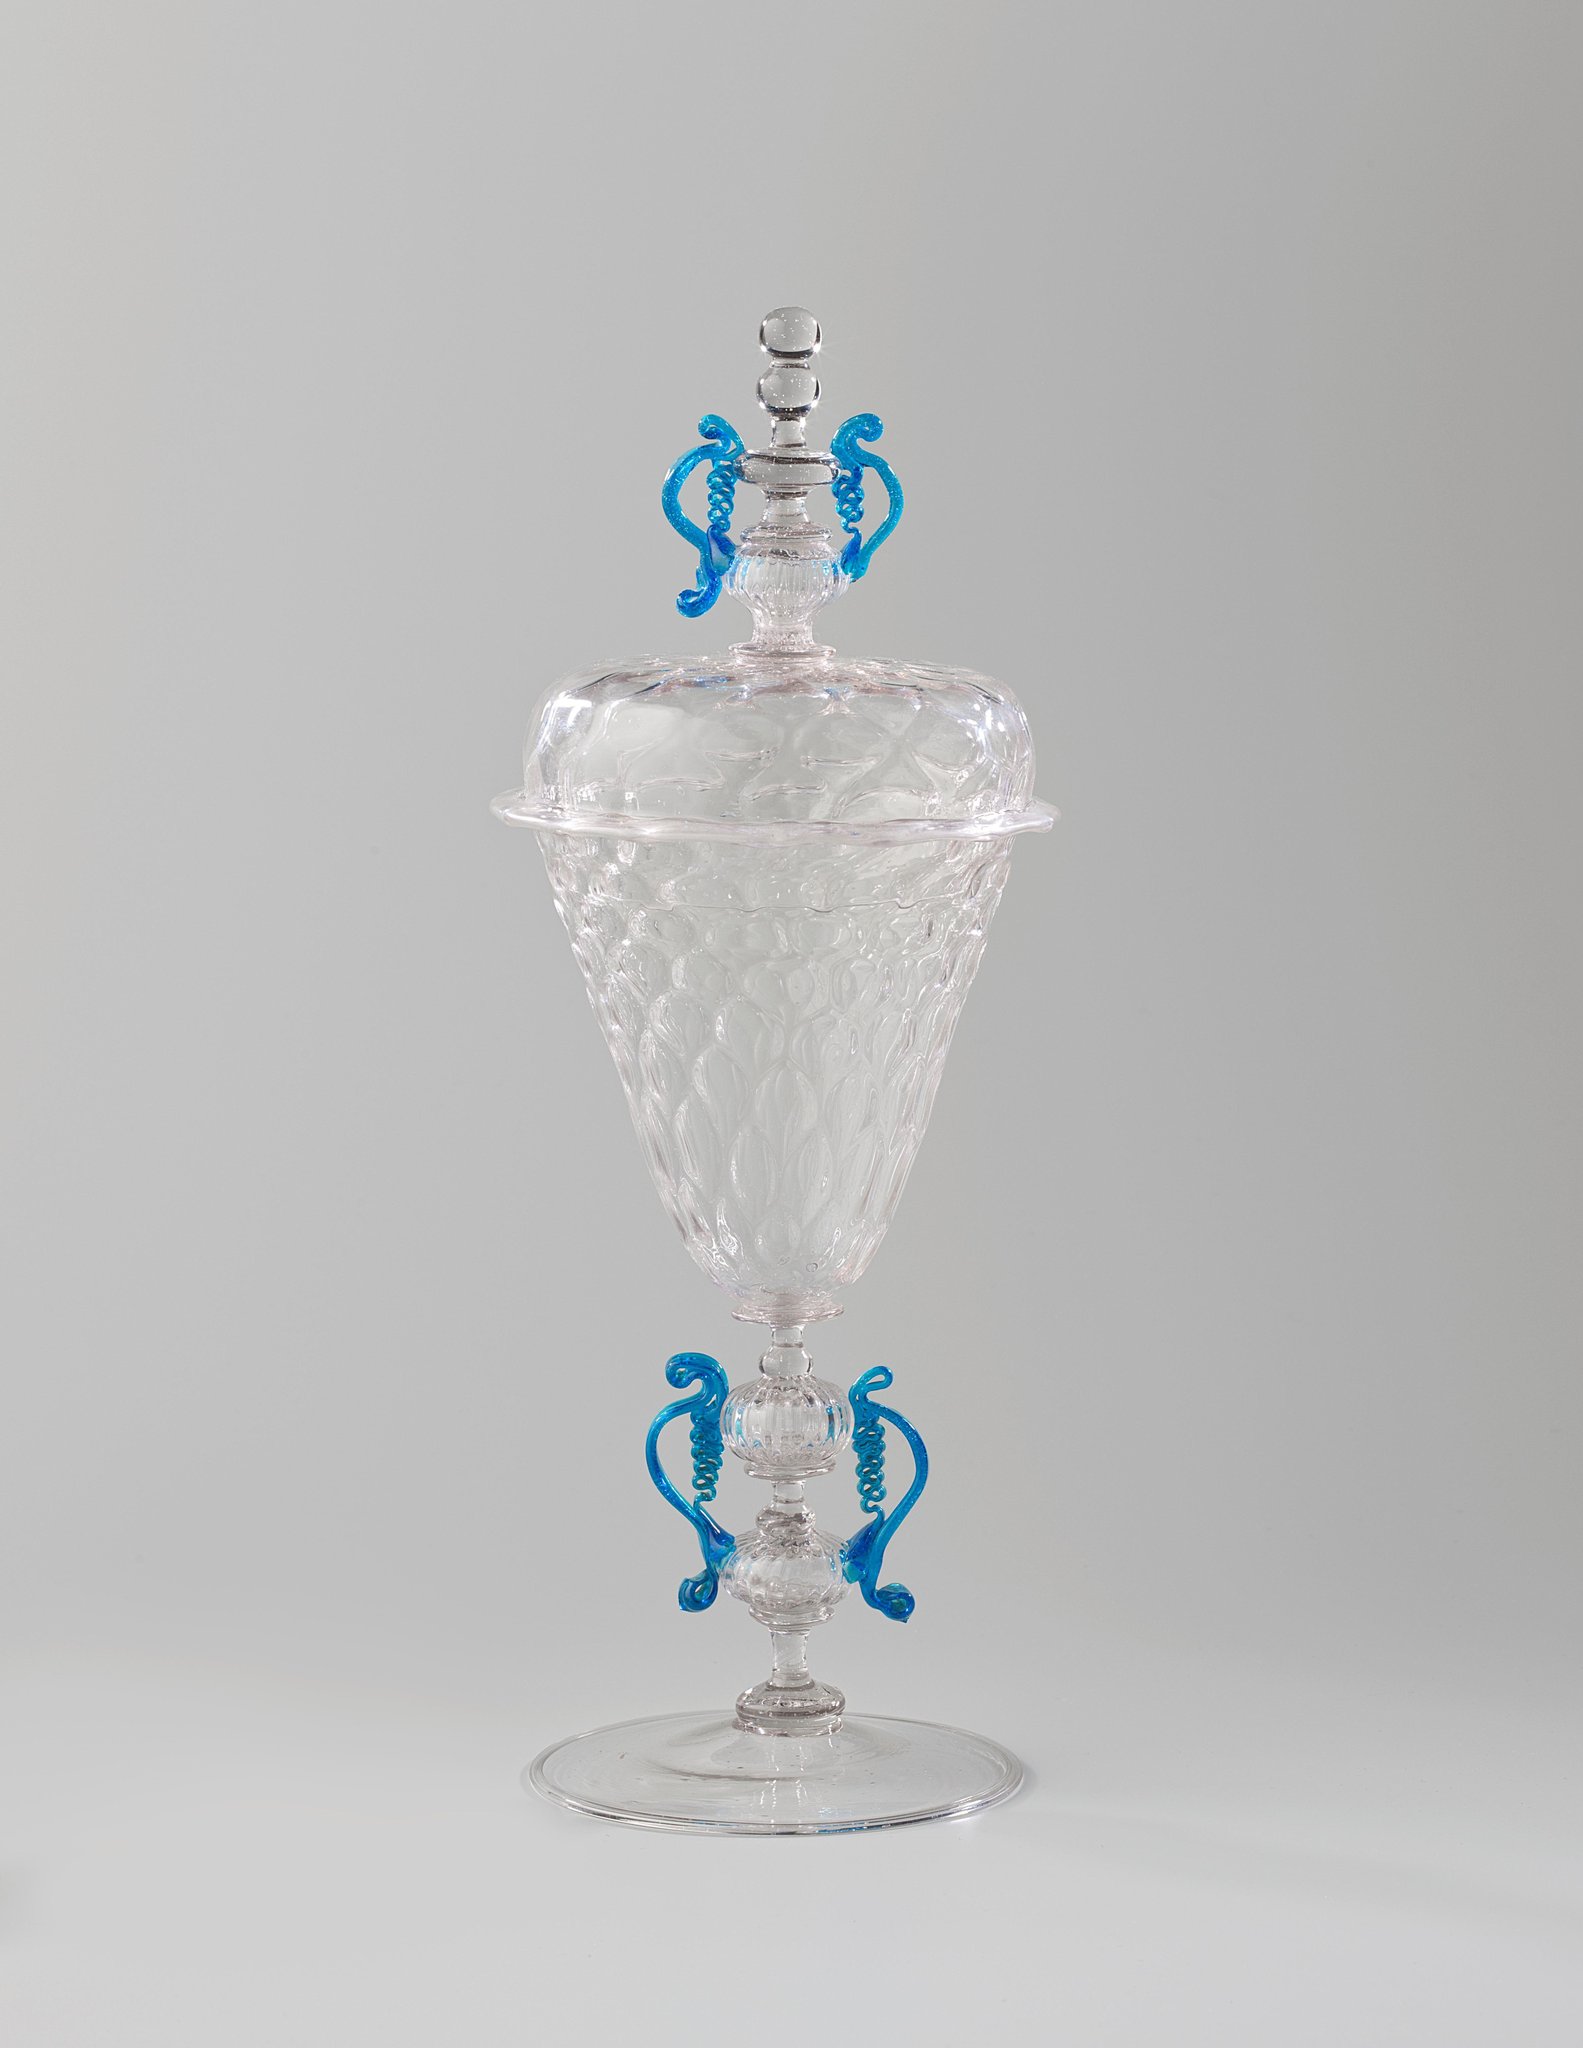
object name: lid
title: Lidded goblet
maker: Anonymous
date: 1650-1700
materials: glass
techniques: façon de venise, glassblowing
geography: netherlands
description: Platte voet met omgeslagen rand. De stam opgebouwd uit twee holle, geribde nodi met ter weerskanten een blauwe vleugel. Conische kelk , optisch geblazen in ruiten. Gewelfde deksel met dubbelgevouwen rand geblazen in hetzelfde motief. De knop opgebouwd uit een holle, geribde nodus, twee schijven en twee bolletjes van blauw glas met ter weerskanten een blauw vleugeltje, gelijk aan dat van de stam.